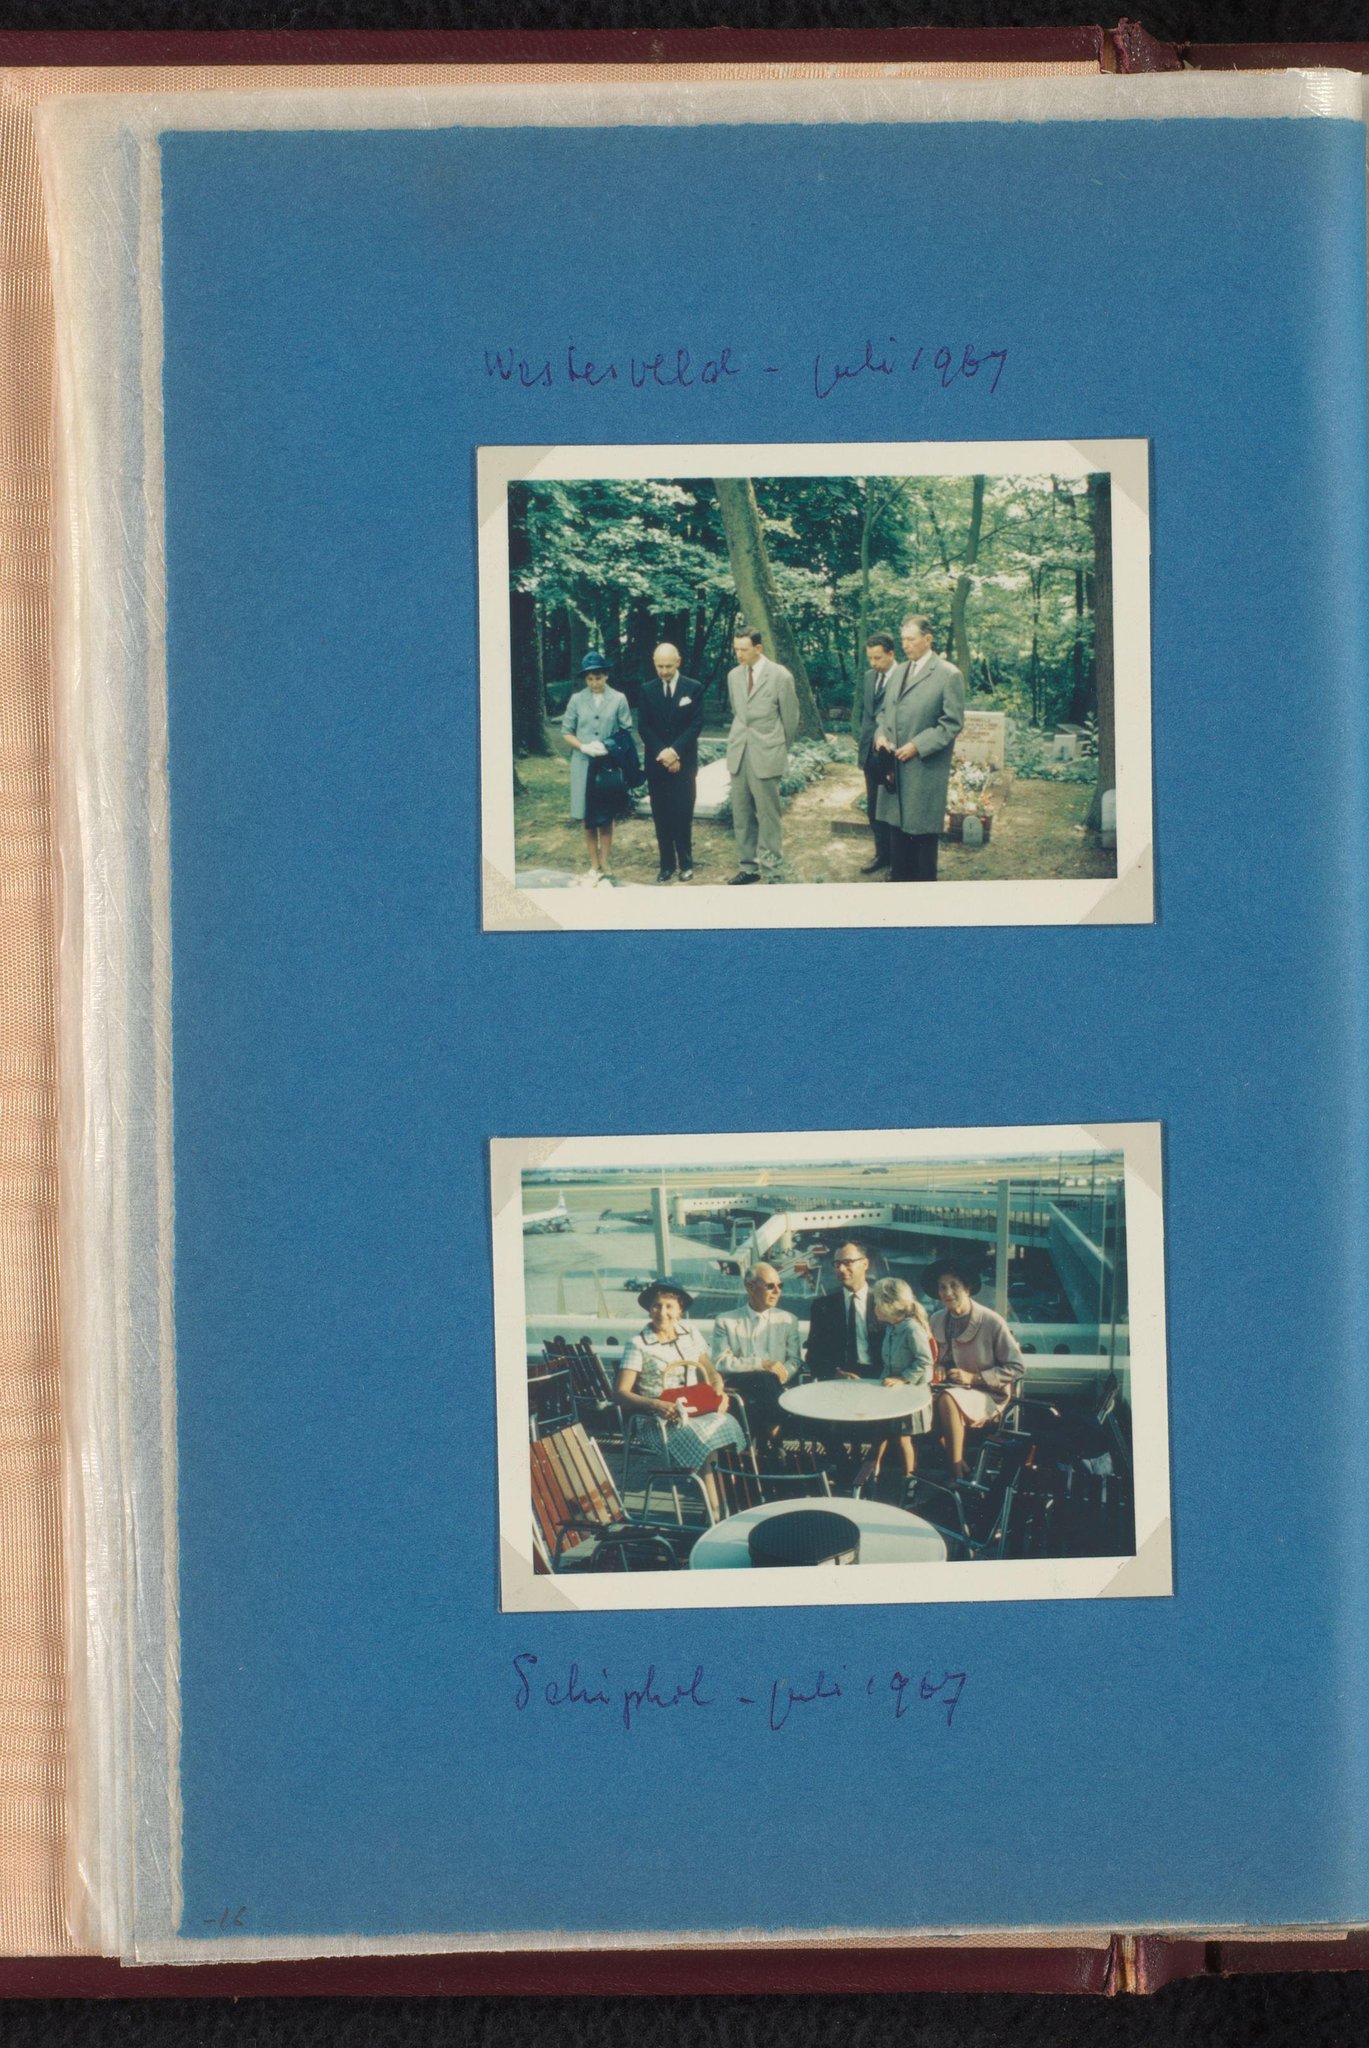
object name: album leaf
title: Norbert van den Berg met een gezelschap bij een graf in Westerveld en op Schiphol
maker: willem jacob van den berg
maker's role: boer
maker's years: 1902-1983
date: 1907-1967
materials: paper, cardboard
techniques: chromogenic print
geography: netherlands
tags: norbert van den berg (1901-1972), airfield, airport, funeral prayers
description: Deze foto's zijn onderdeel van een album.